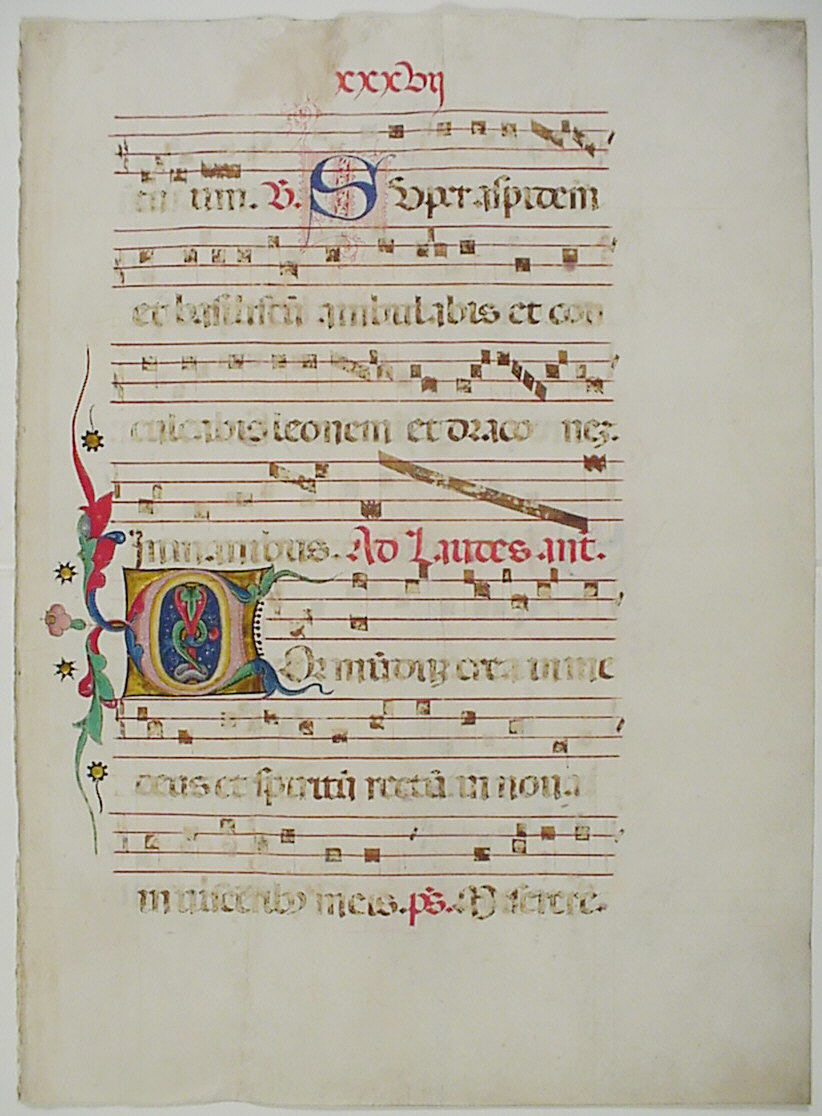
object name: antiphonary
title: Manuscript Leaf with Initial C, from an Antiphonary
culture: italian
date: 1401-1500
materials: ink, metal leaf, parchment, paint